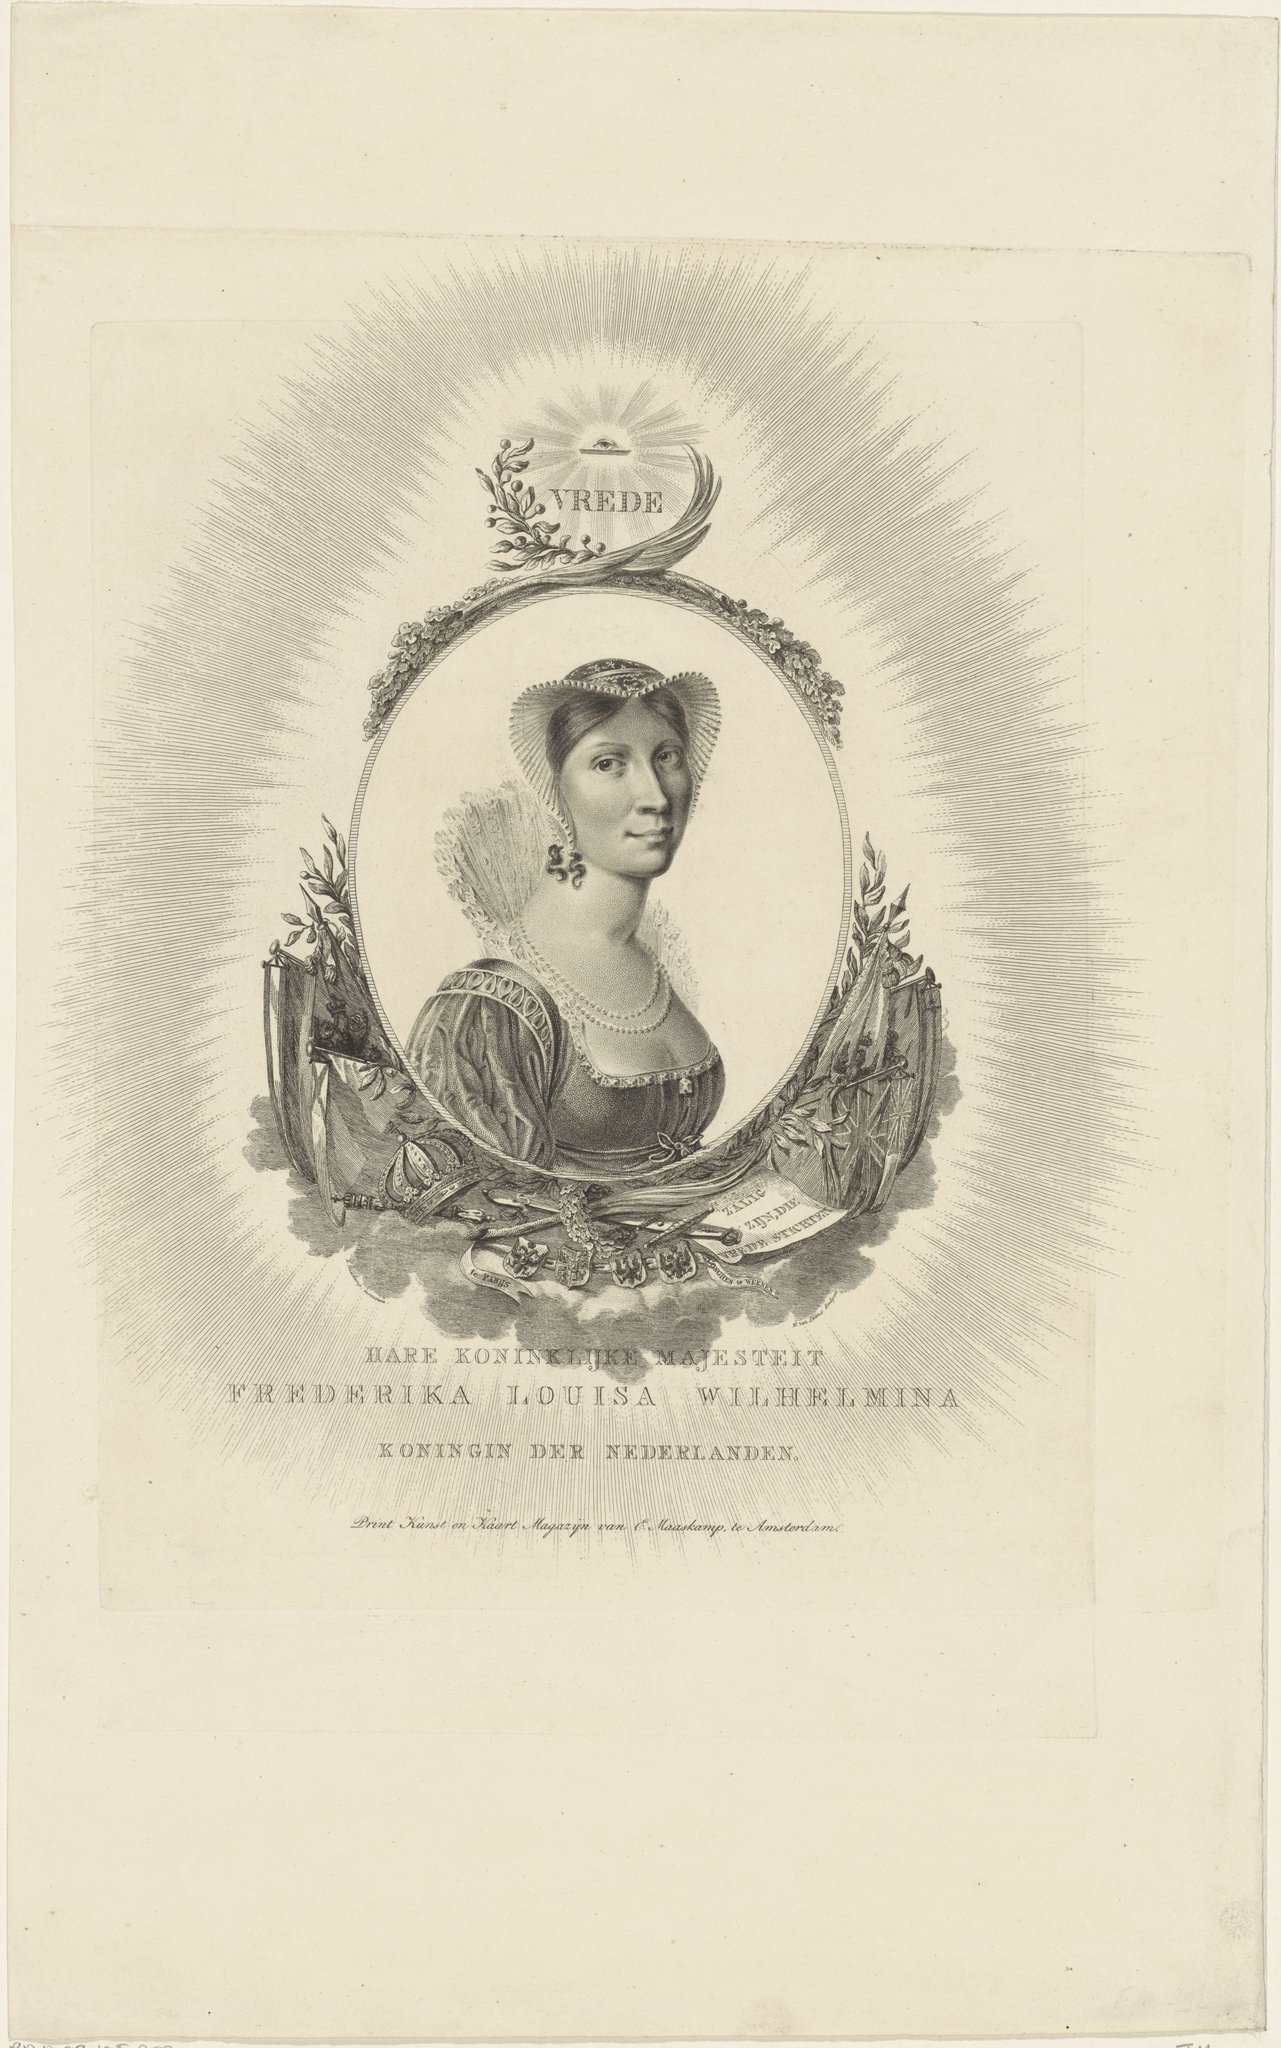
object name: print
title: Portret van Wilhelmina van Pruisen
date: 1815-1834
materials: paper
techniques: engraving, etching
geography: amsterdam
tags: berlin, the hague, wilhelmina frederica louisa (koningin der nederlanden)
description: Portret van Wilhelmina in een ovaal. Daar omheen een aantal allegorische objecten en een stralenkrans. In de ondermarge haar naam en titel.